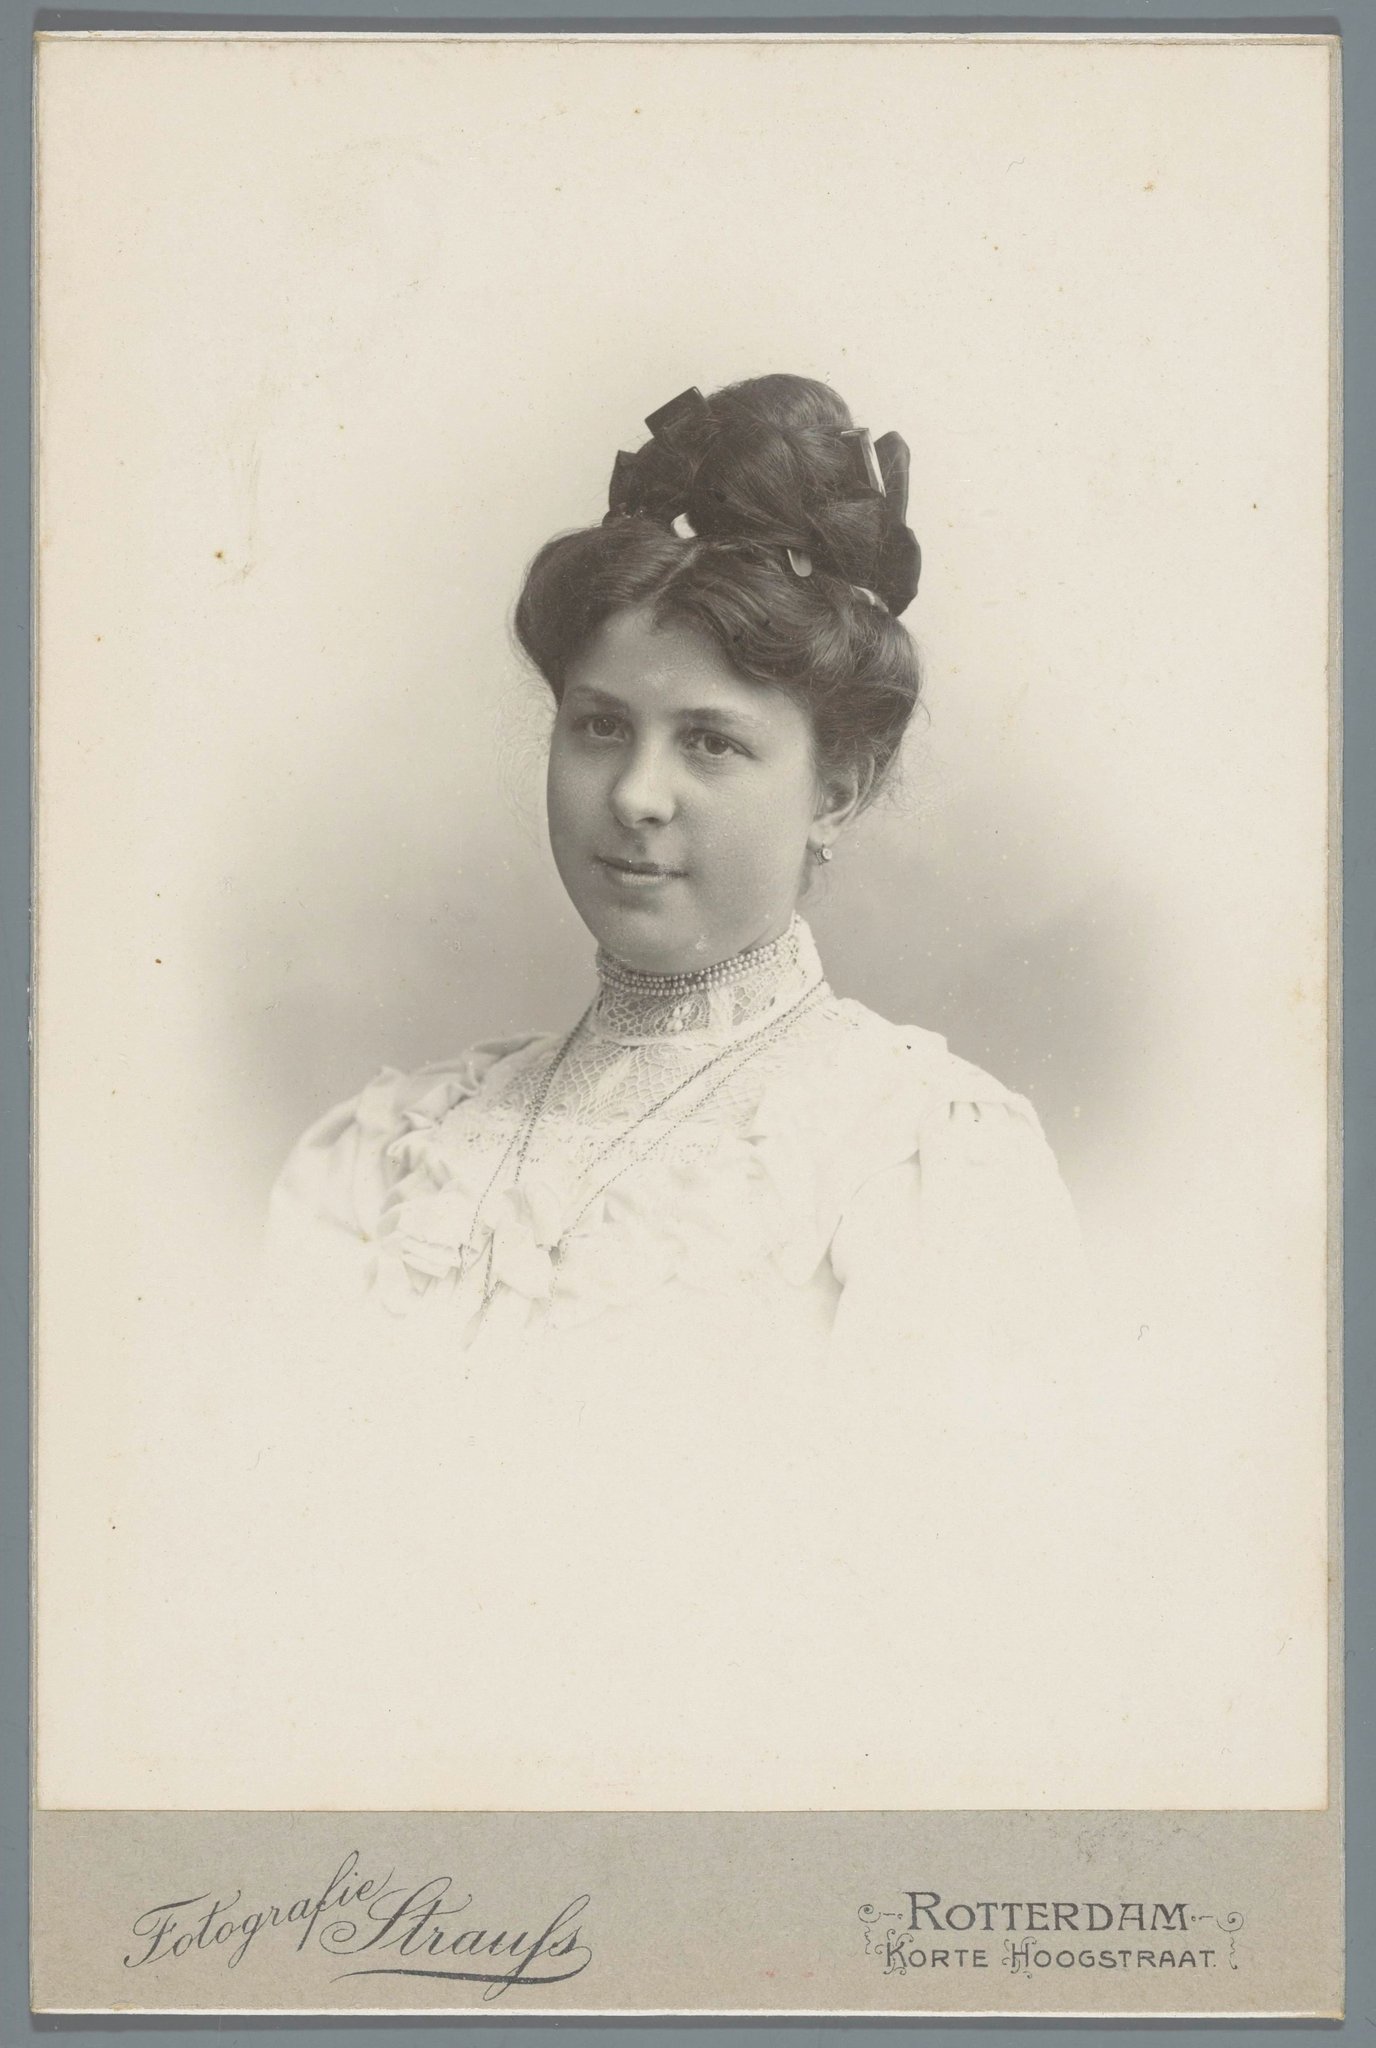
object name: cabinet photograph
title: Portret van een onbekende vrouw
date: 1910-1920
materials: cardboard, photographic support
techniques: gelatin silver print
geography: rotterdam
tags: adult woman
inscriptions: inscription: ‘Fotografie Strauss Rotterdam in het gebouw de Galerij Korte Hoogstraat (...) Vergrootingen in alle Formaten.’